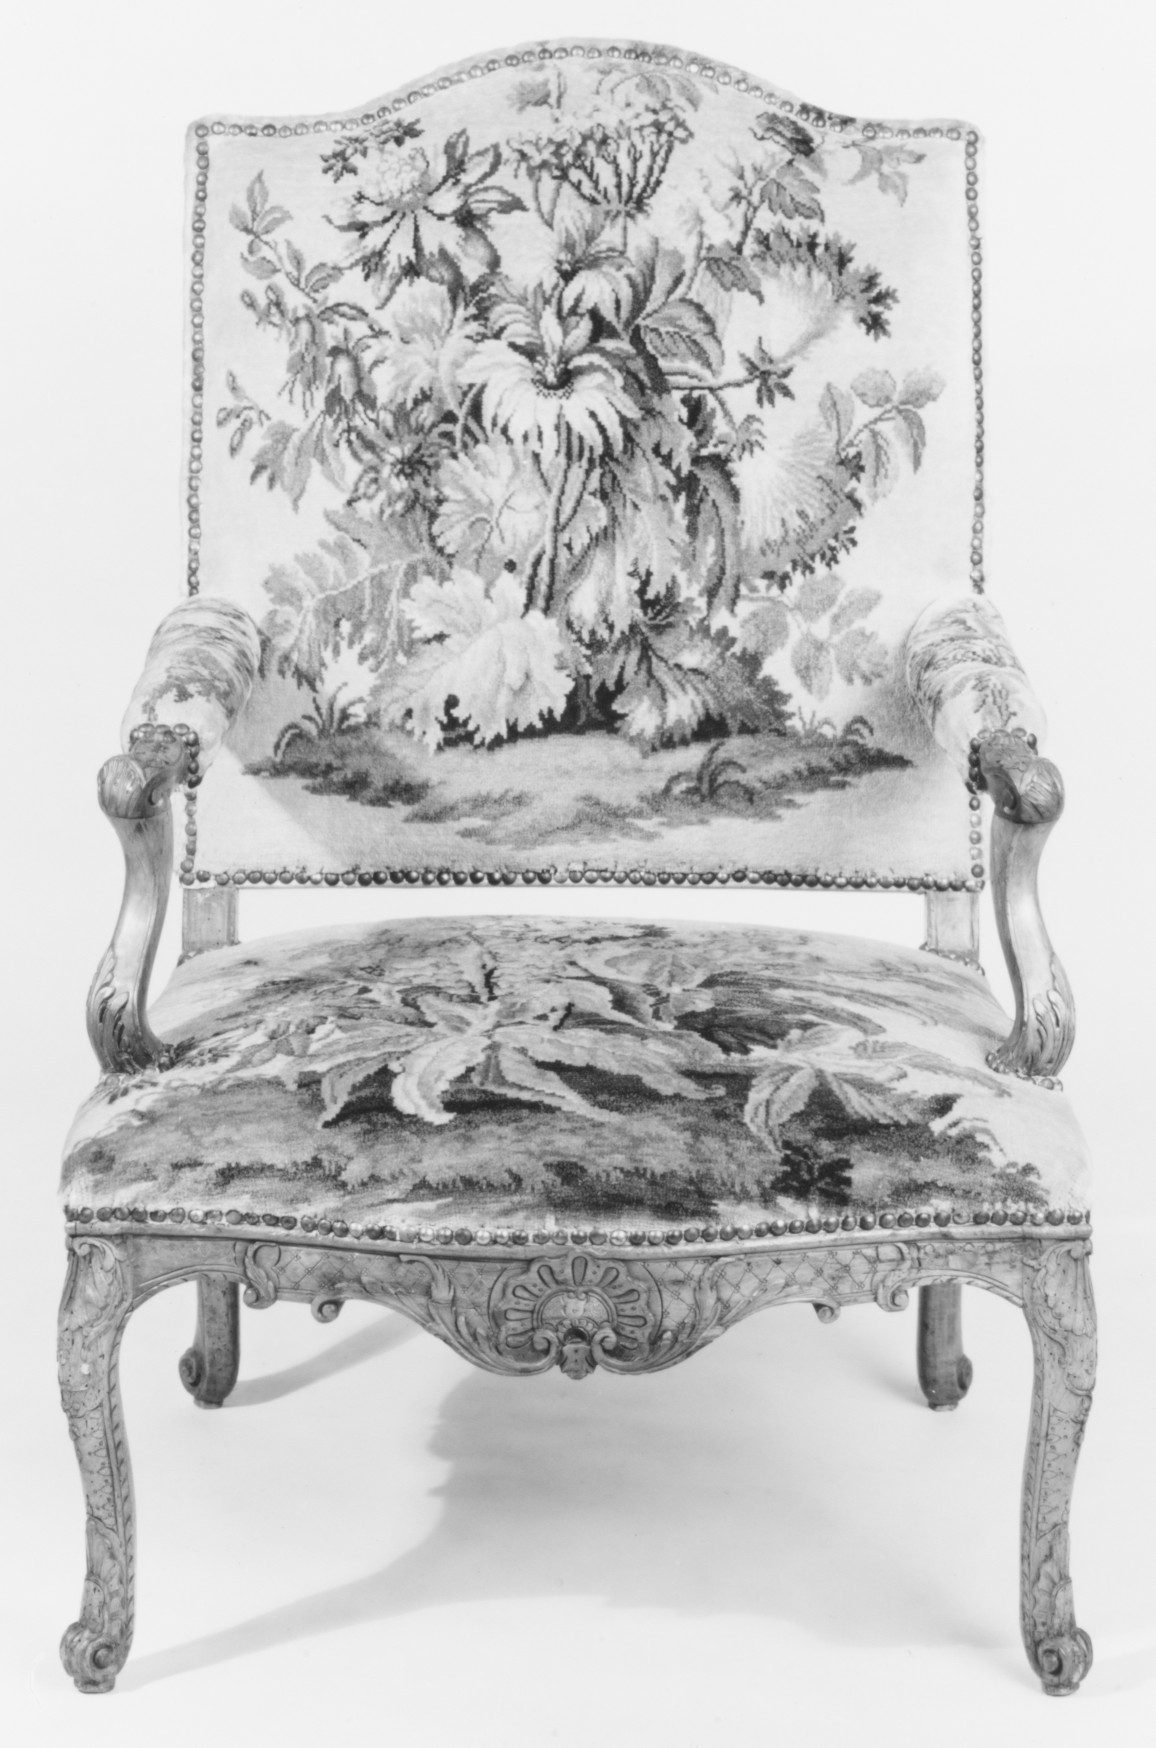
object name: armchair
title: Armchair (one of a pair)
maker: savonnerie manufactory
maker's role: manufactory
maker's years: 1626-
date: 1725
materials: wood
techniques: carving, tapestry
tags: flowers